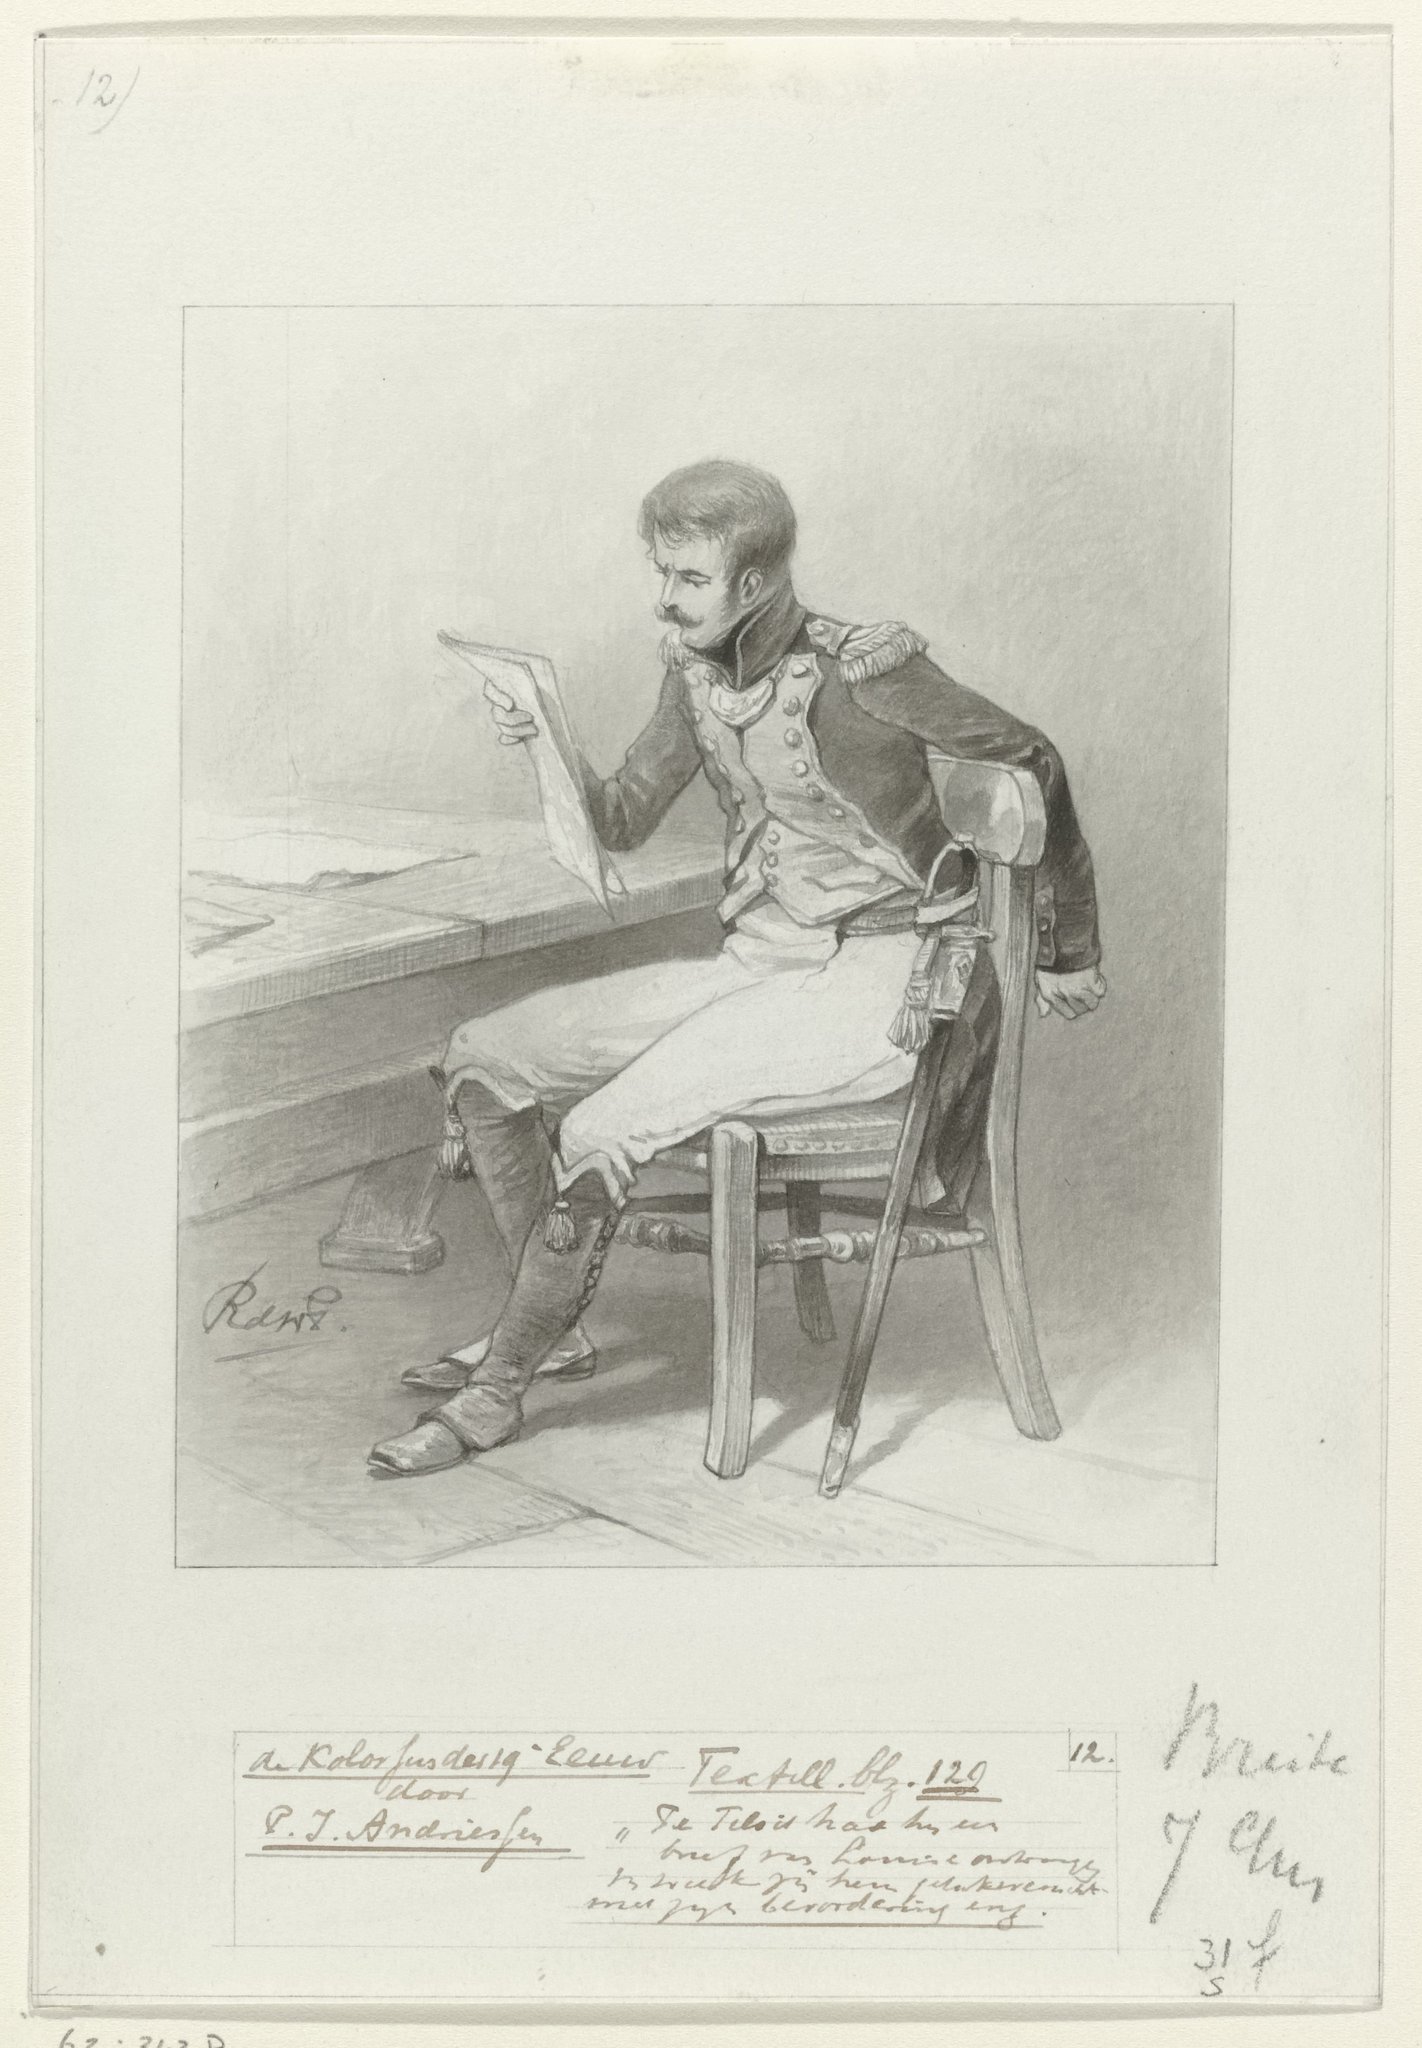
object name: drawing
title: Ontwerp voor illustratie voor De Kolossus der Negentiende Eeuw door P.J. Andriessen (Textill., blz. 129); scène uit het leven van Napoleon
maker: george lodewijk de wetstein pfister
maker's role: draughtsman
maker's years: 1867-1942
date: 1877-1942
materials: ink, paper, pencil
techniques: brush, pen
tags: napoleon i (emperor of the french), (andriessen, de kolossus der negentiende eeuw) specific works of literature (with author, title), historical persons, illustration ~ printed matter, book, historical events and situations